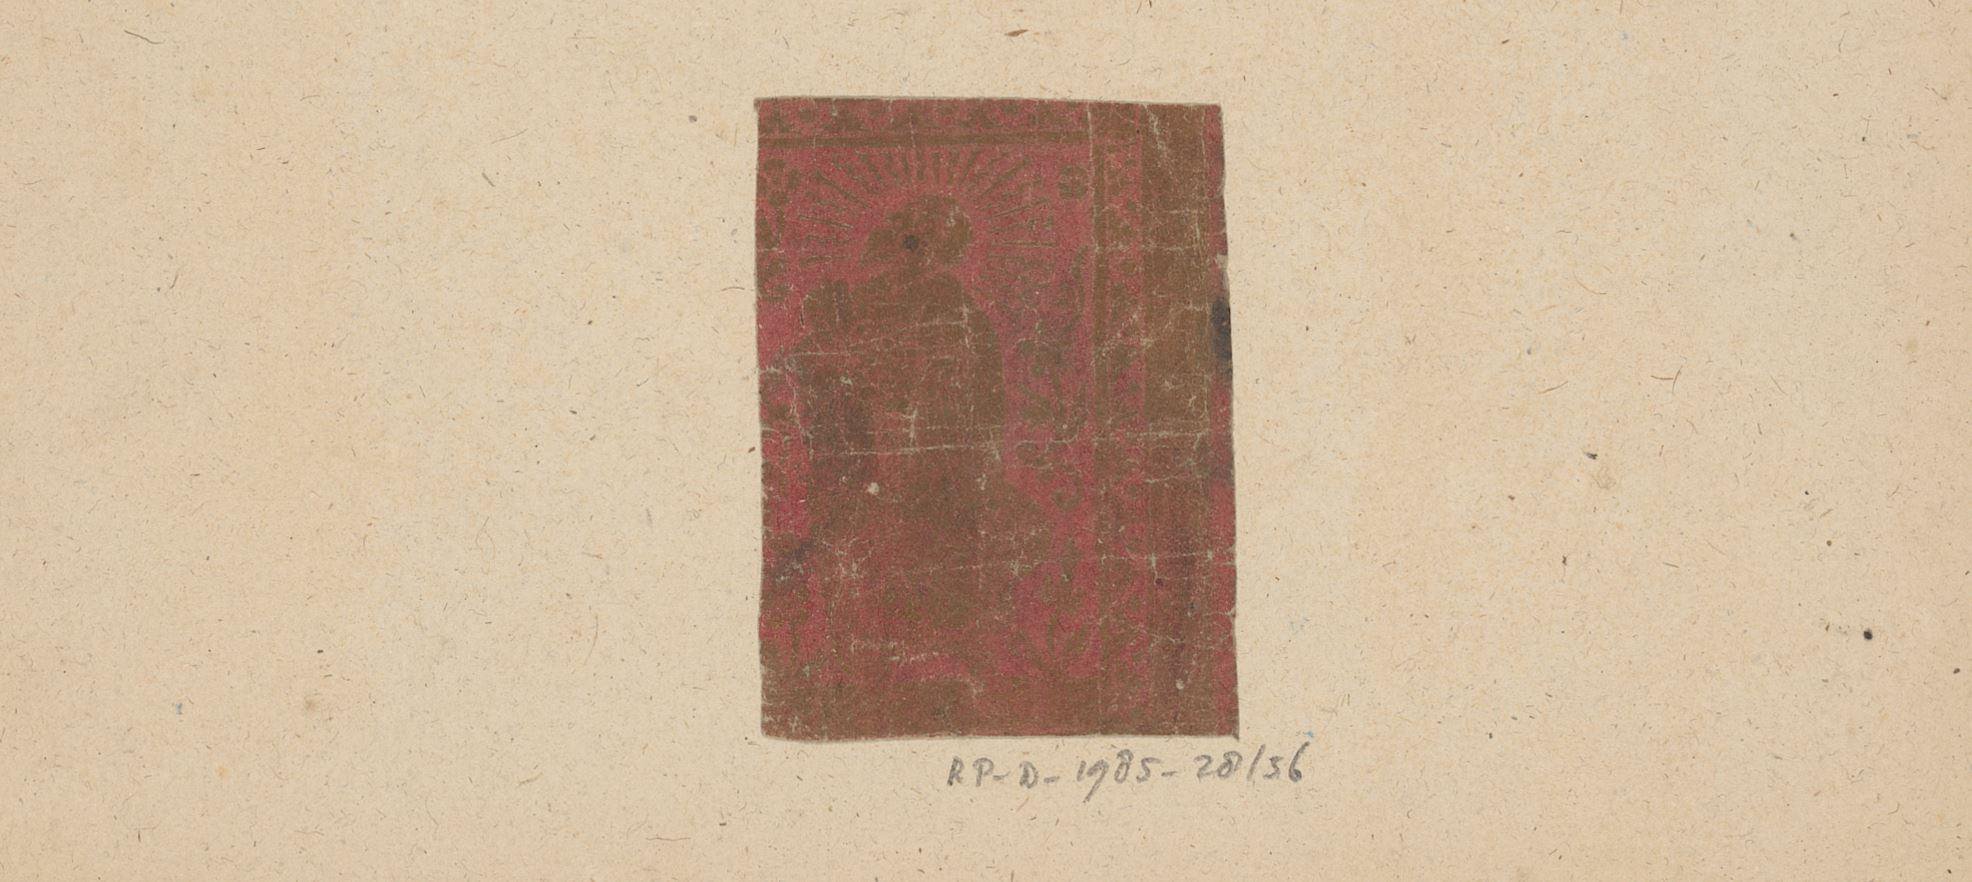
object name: brocade paper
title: Fragment met een apostel in sierkader met bloemen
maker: Anonymous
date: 1700-1850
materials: gold leaf, paper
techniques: relief print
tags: saints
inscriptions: collector's mark: Lugt 2228, collector's mark: Lugt 2760